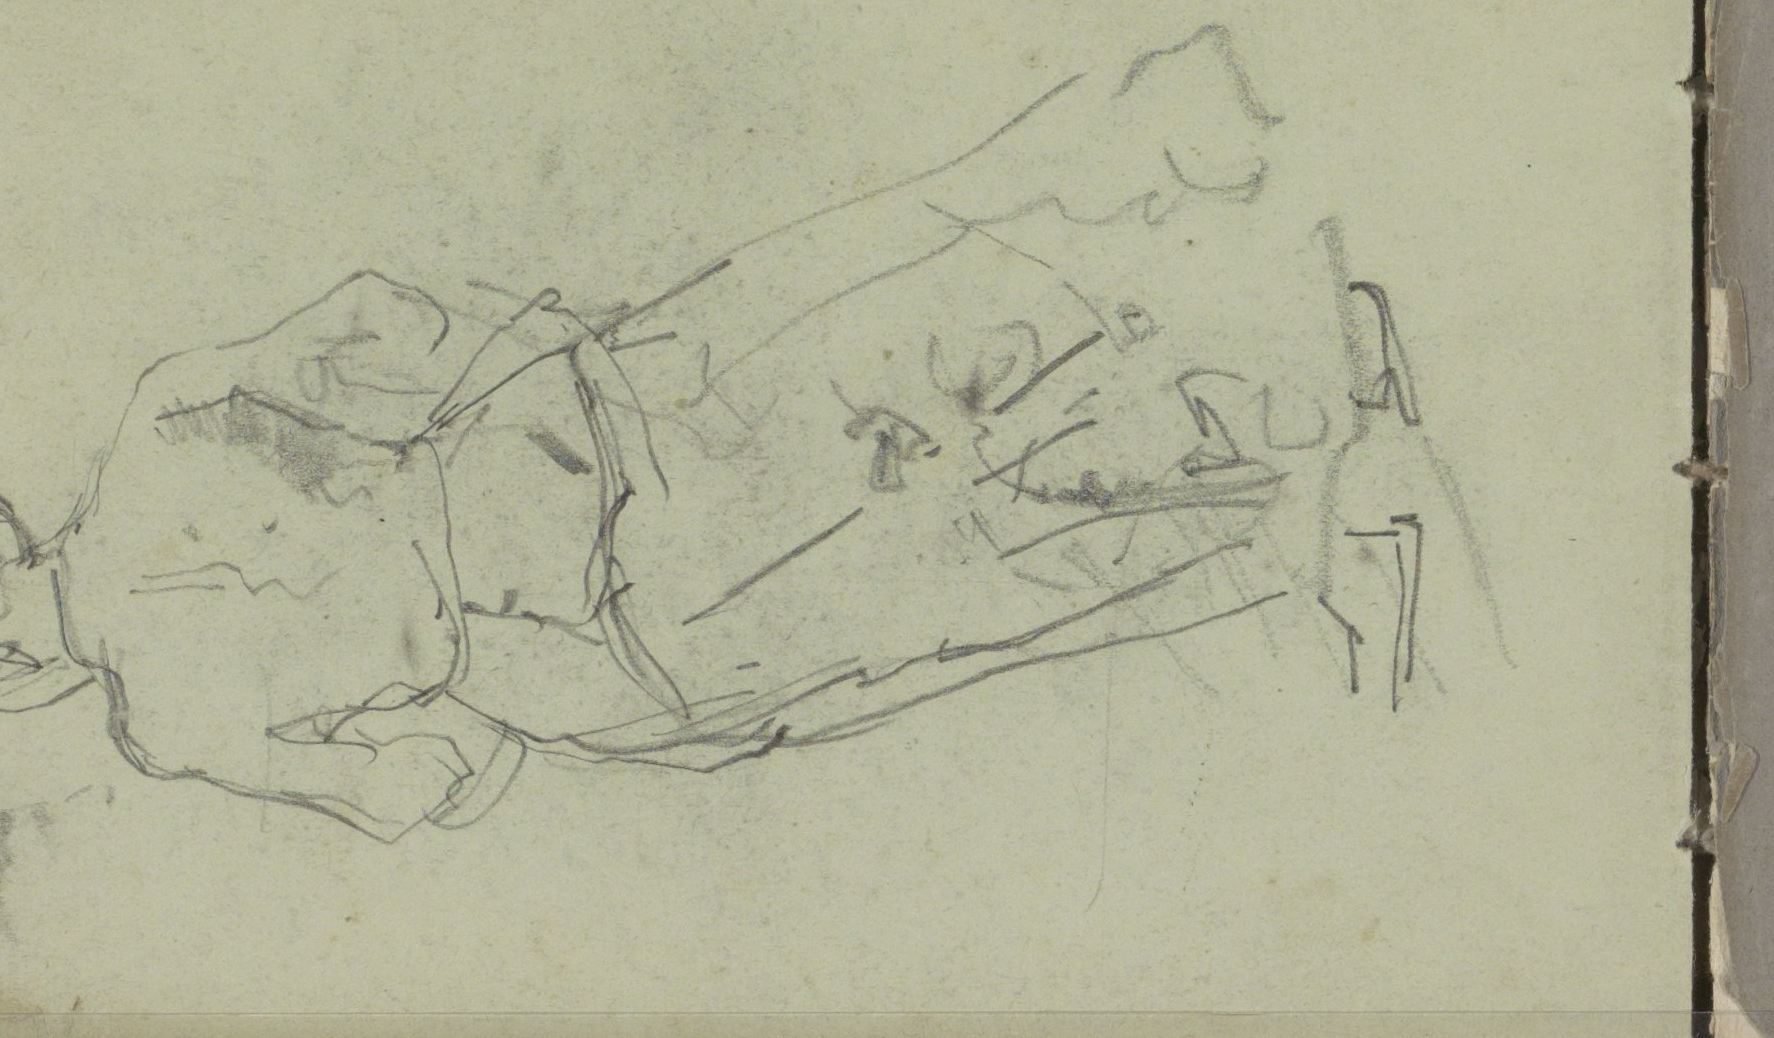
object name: sketchbook leaf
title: Vrouw, op de rug gezien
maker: george hendrik breitner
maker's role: draughtsman, painter, print maker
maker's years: 1857-1923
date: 1881-1883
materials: paper, pencil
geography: north brabant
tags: adult woman (+ back view)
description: Pagina 45 uit een schetsboek met 42 bladen.